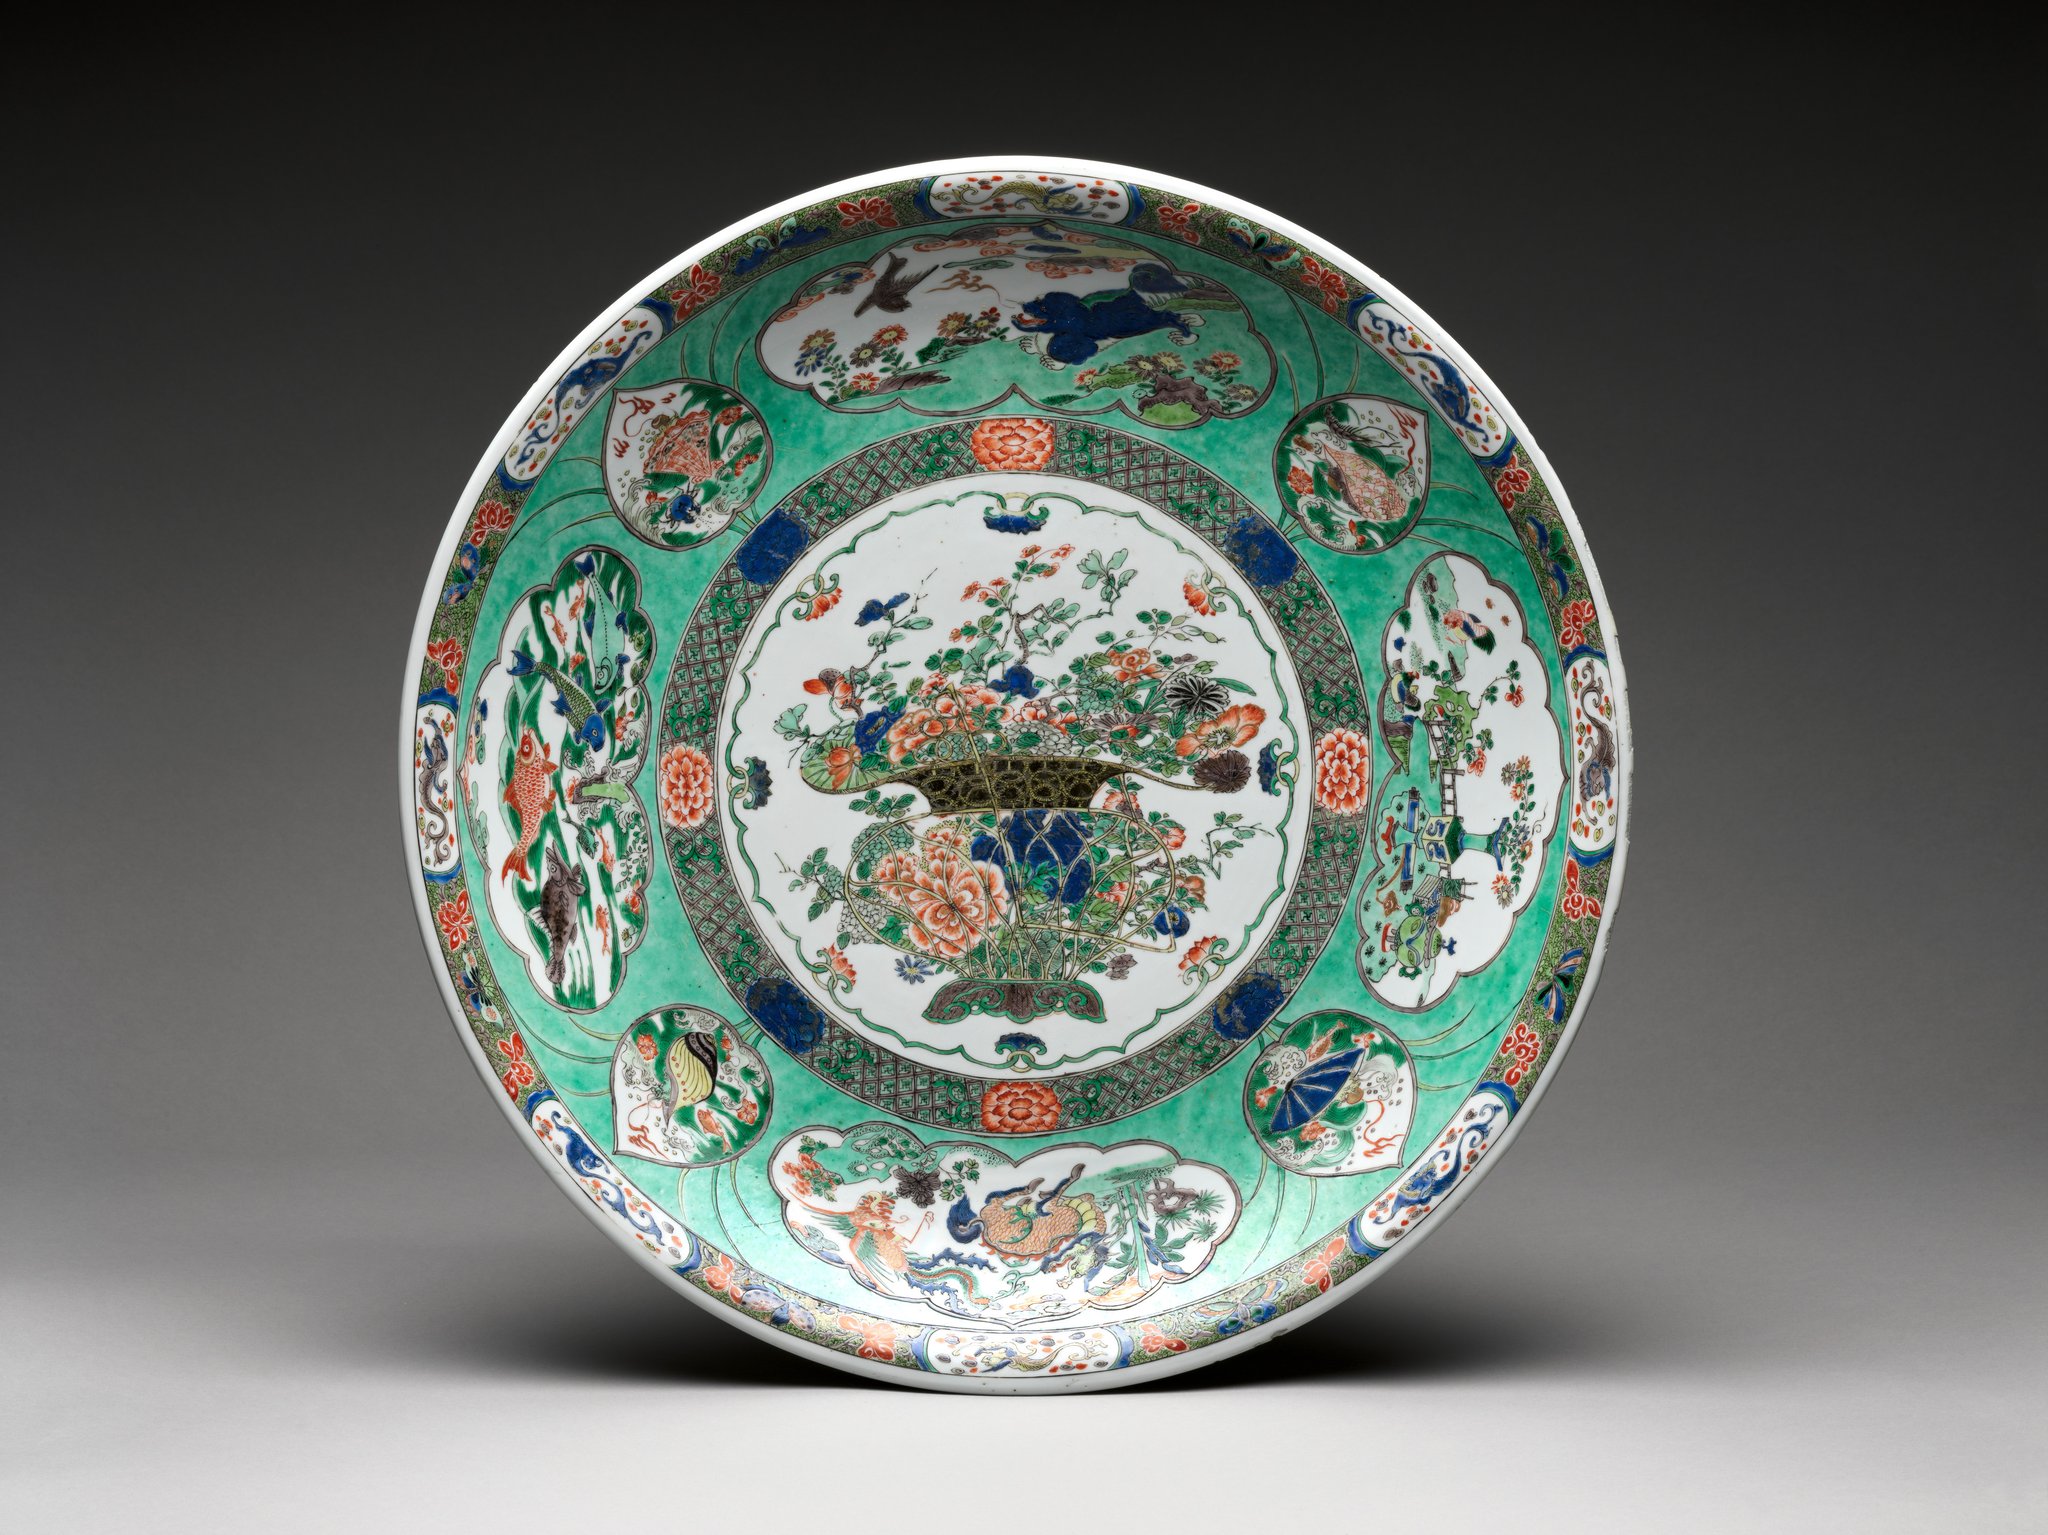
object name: plate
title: Plate with Basket of Auspicious Flowers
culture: chinese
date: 1667-1733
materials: enamel, glaze, porcelain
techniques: painting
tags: flowers